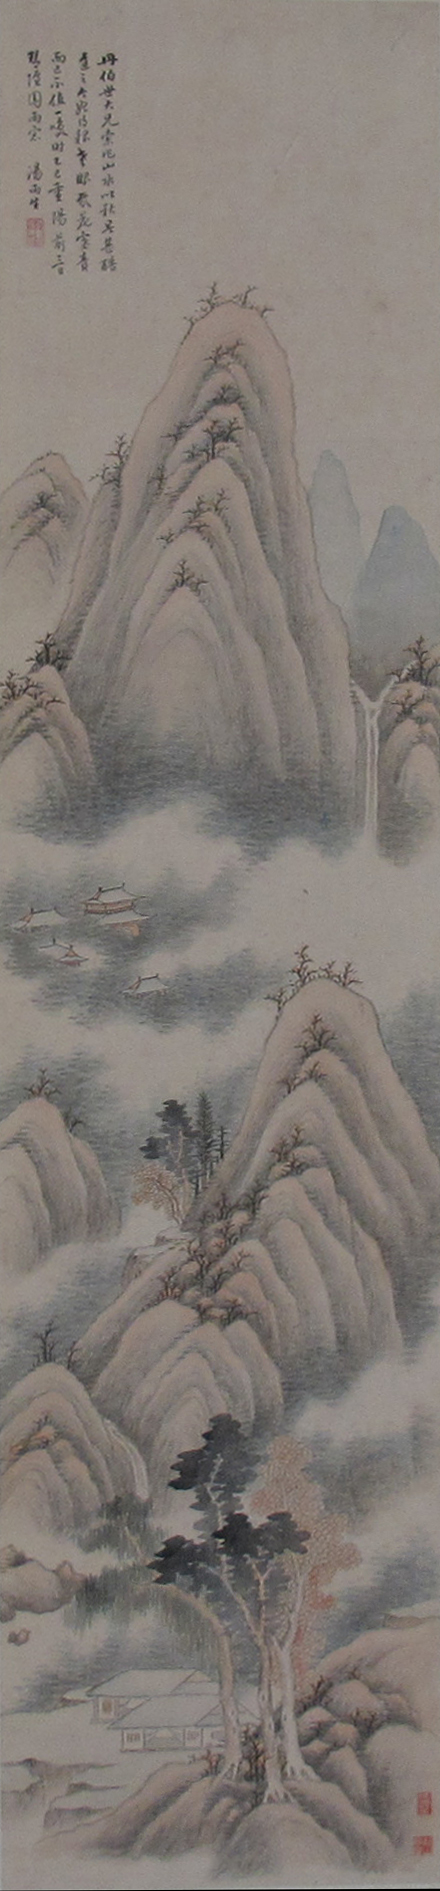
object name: hanging scroll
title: Landscape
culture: chinese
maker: tang yifen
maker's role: artist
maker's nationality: chinese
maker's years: 1778-1853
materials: ink, paper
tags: mountains,landscapes